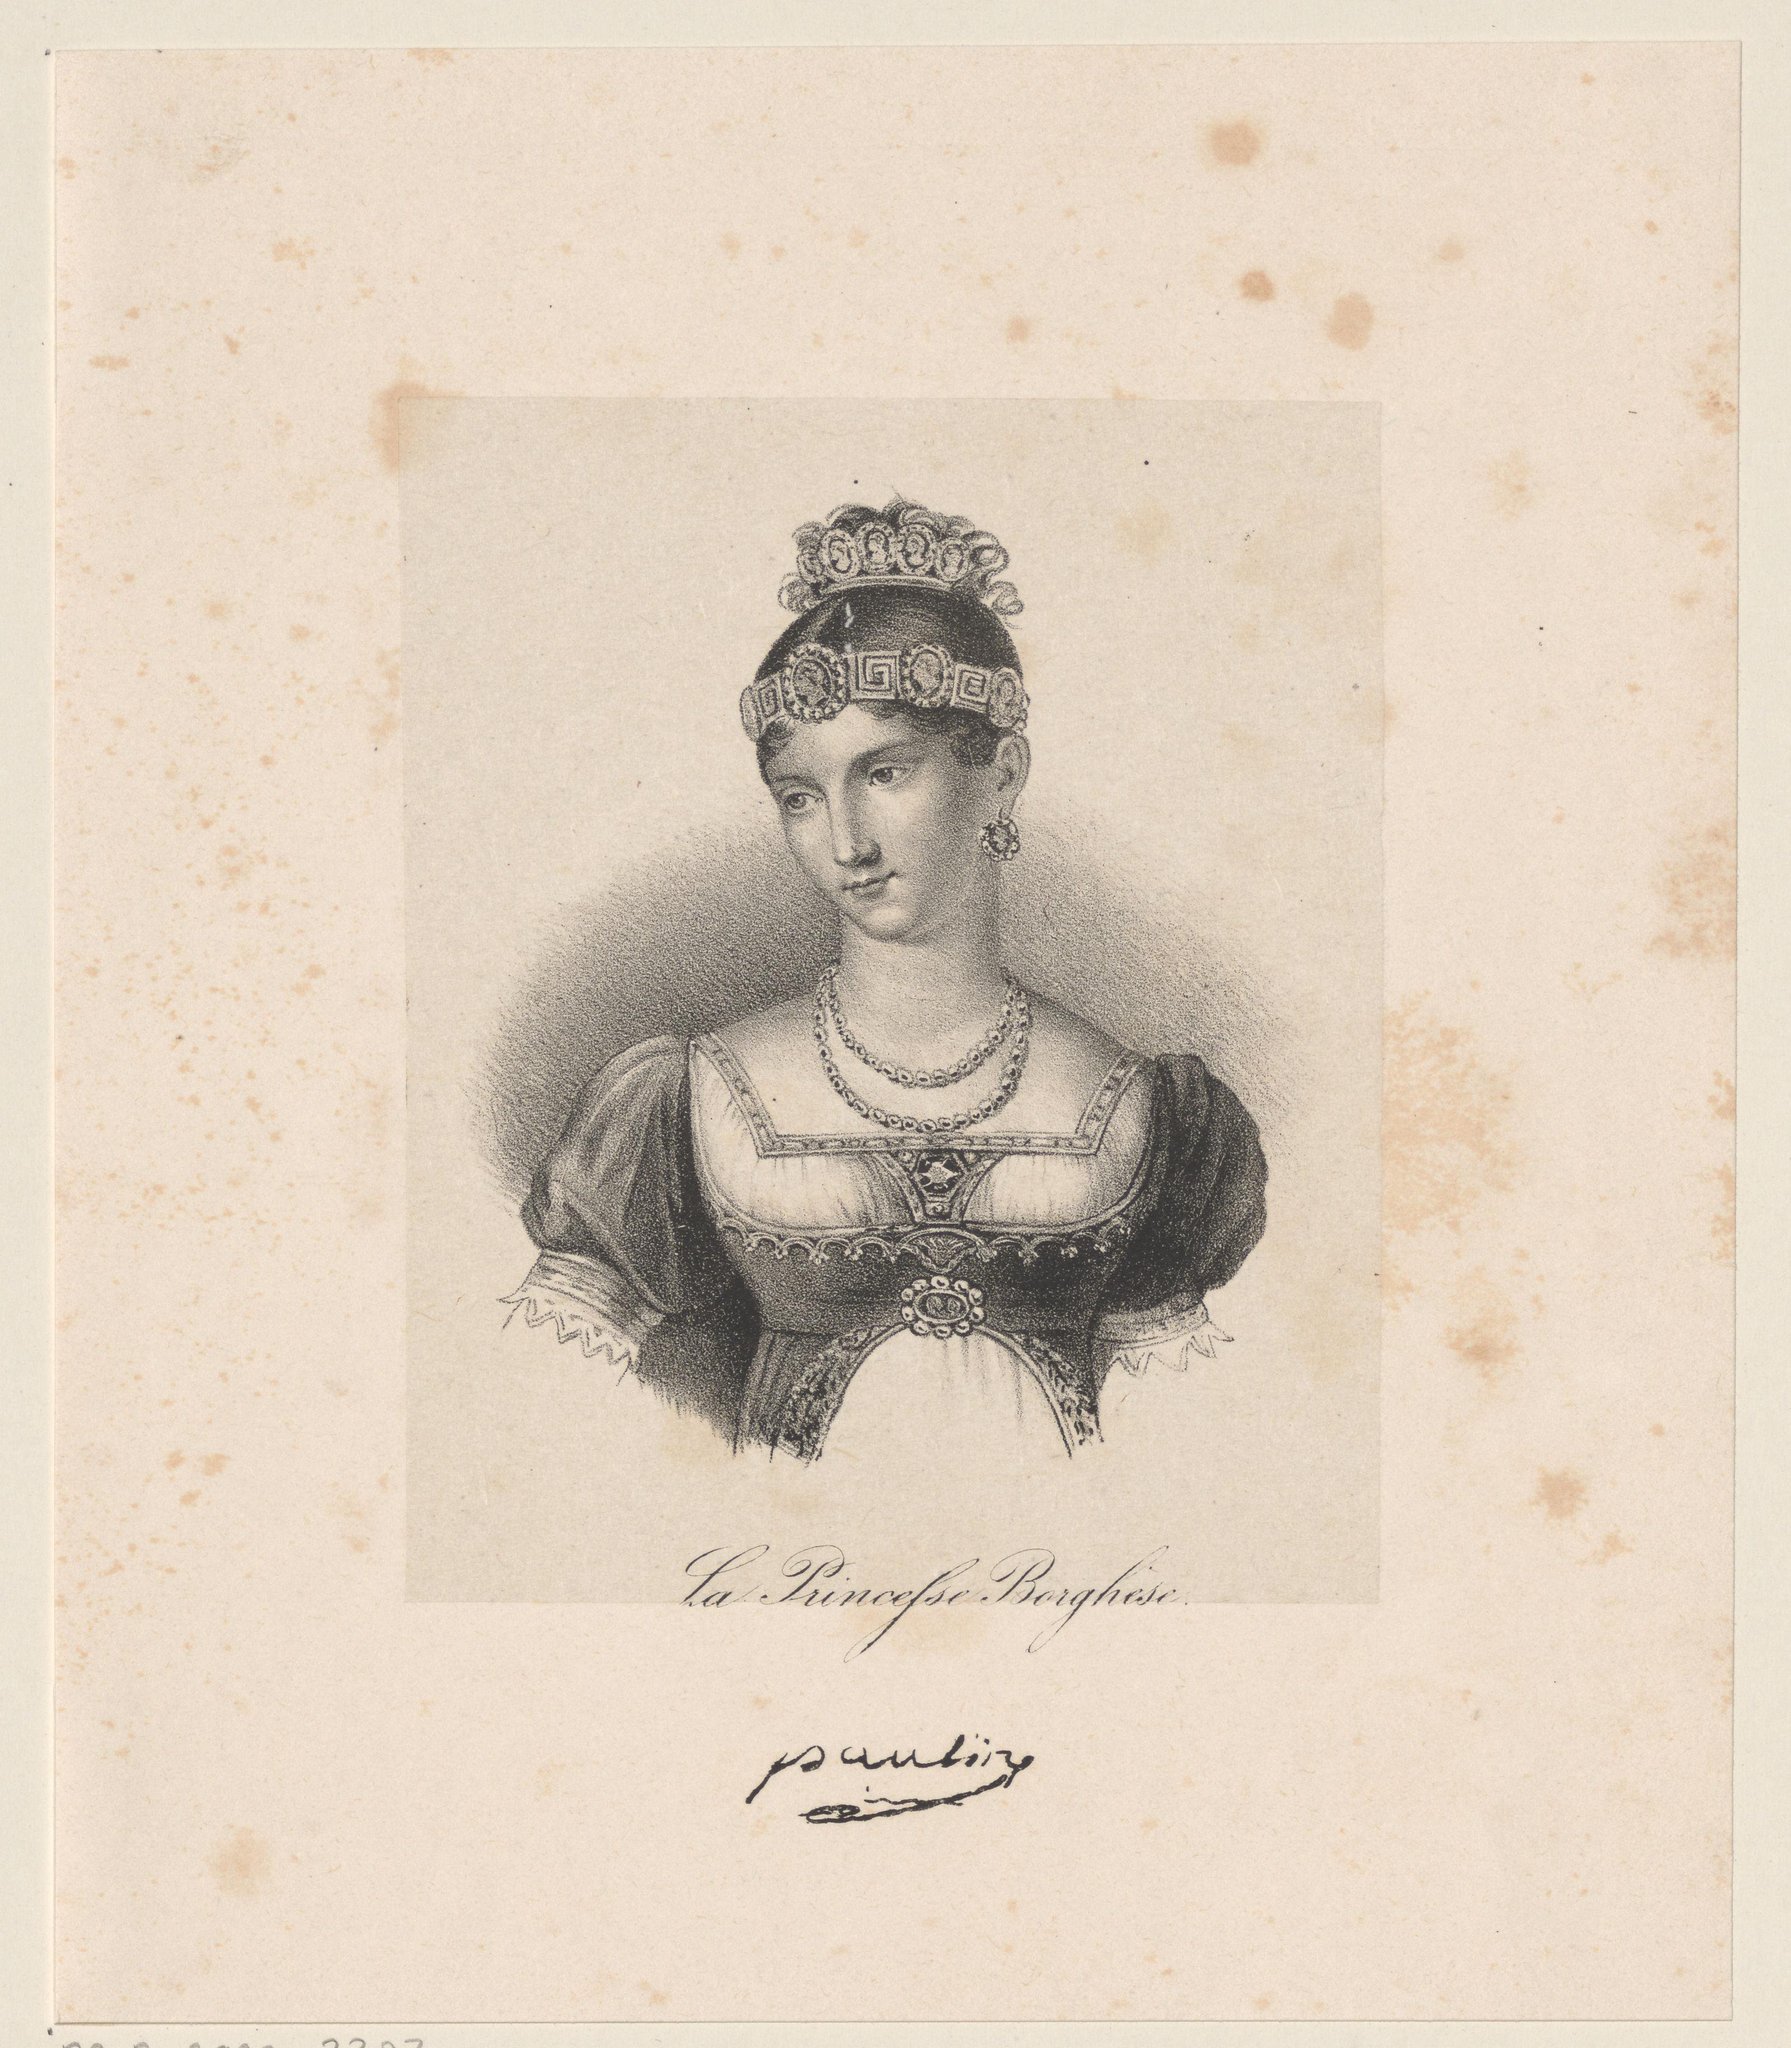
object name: print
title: Portret van Maria Pauline Bonaparte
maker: Anonymous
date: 1803-1849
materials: paper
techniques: lithograph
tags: historical persons - bb - woman